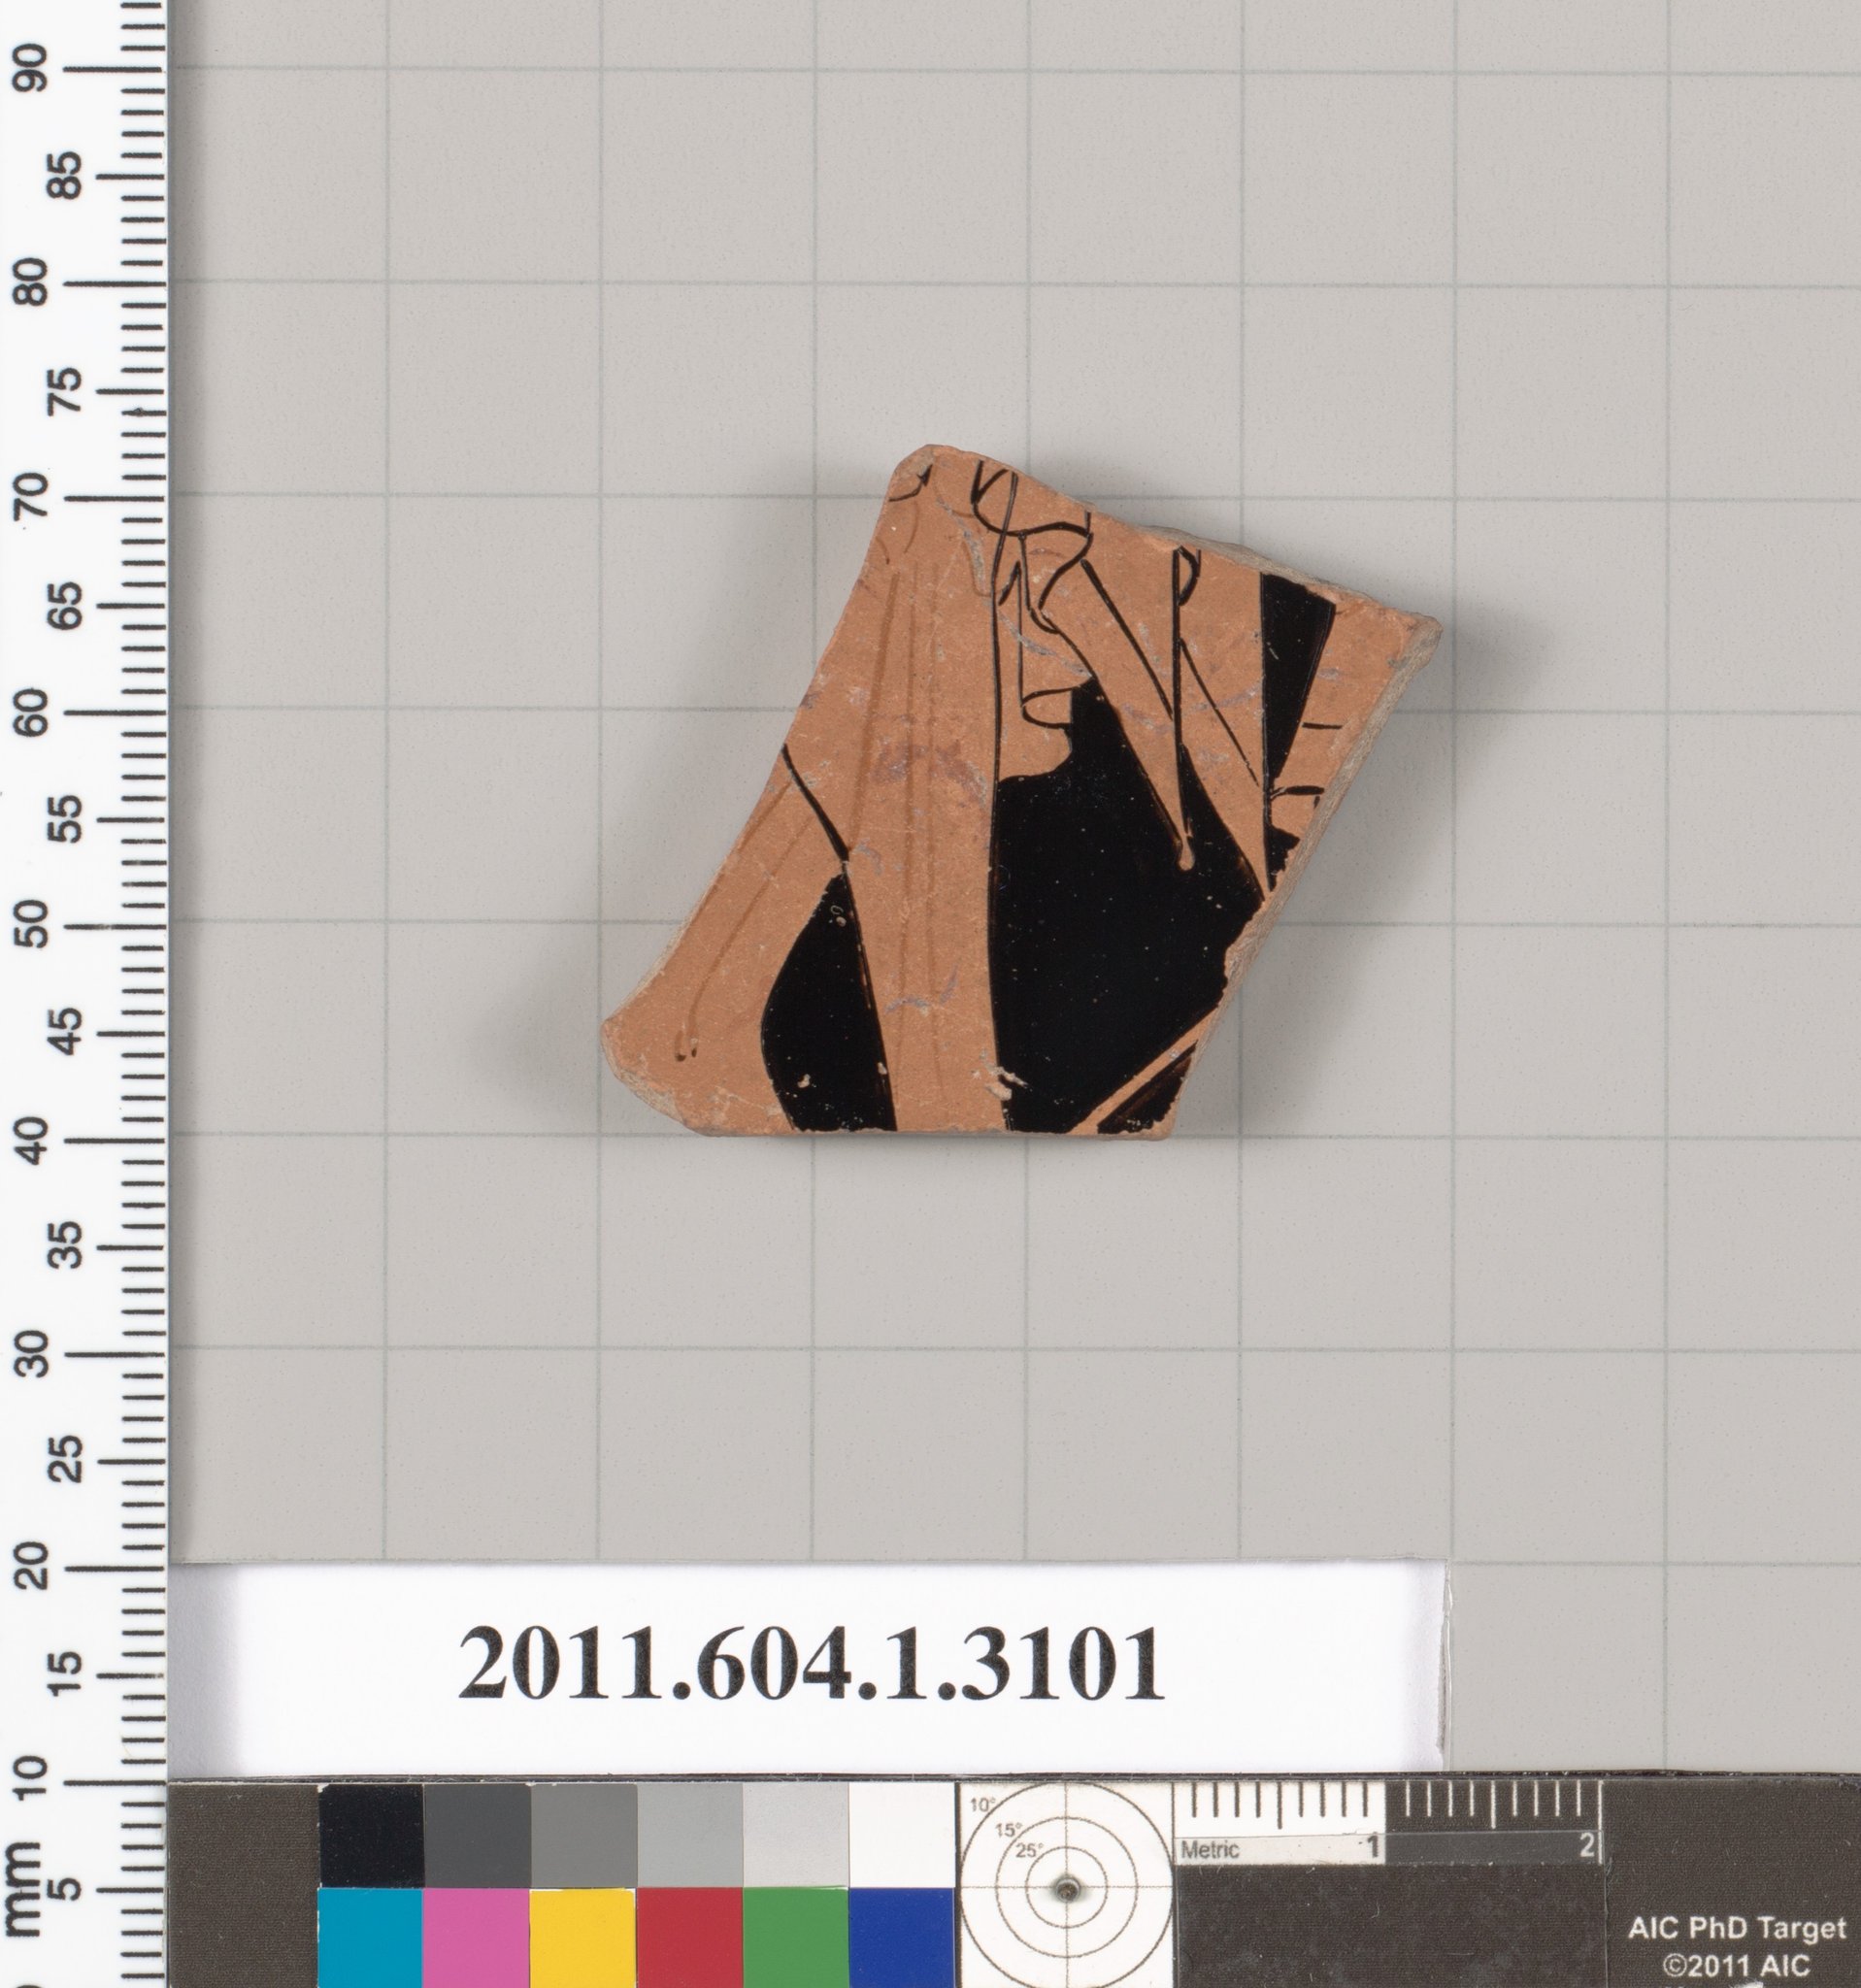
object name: kylix fragment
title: Terracotta fragment of a kylix (drinking cup)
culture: greek, attic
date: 490-480 BCE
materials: terracotta